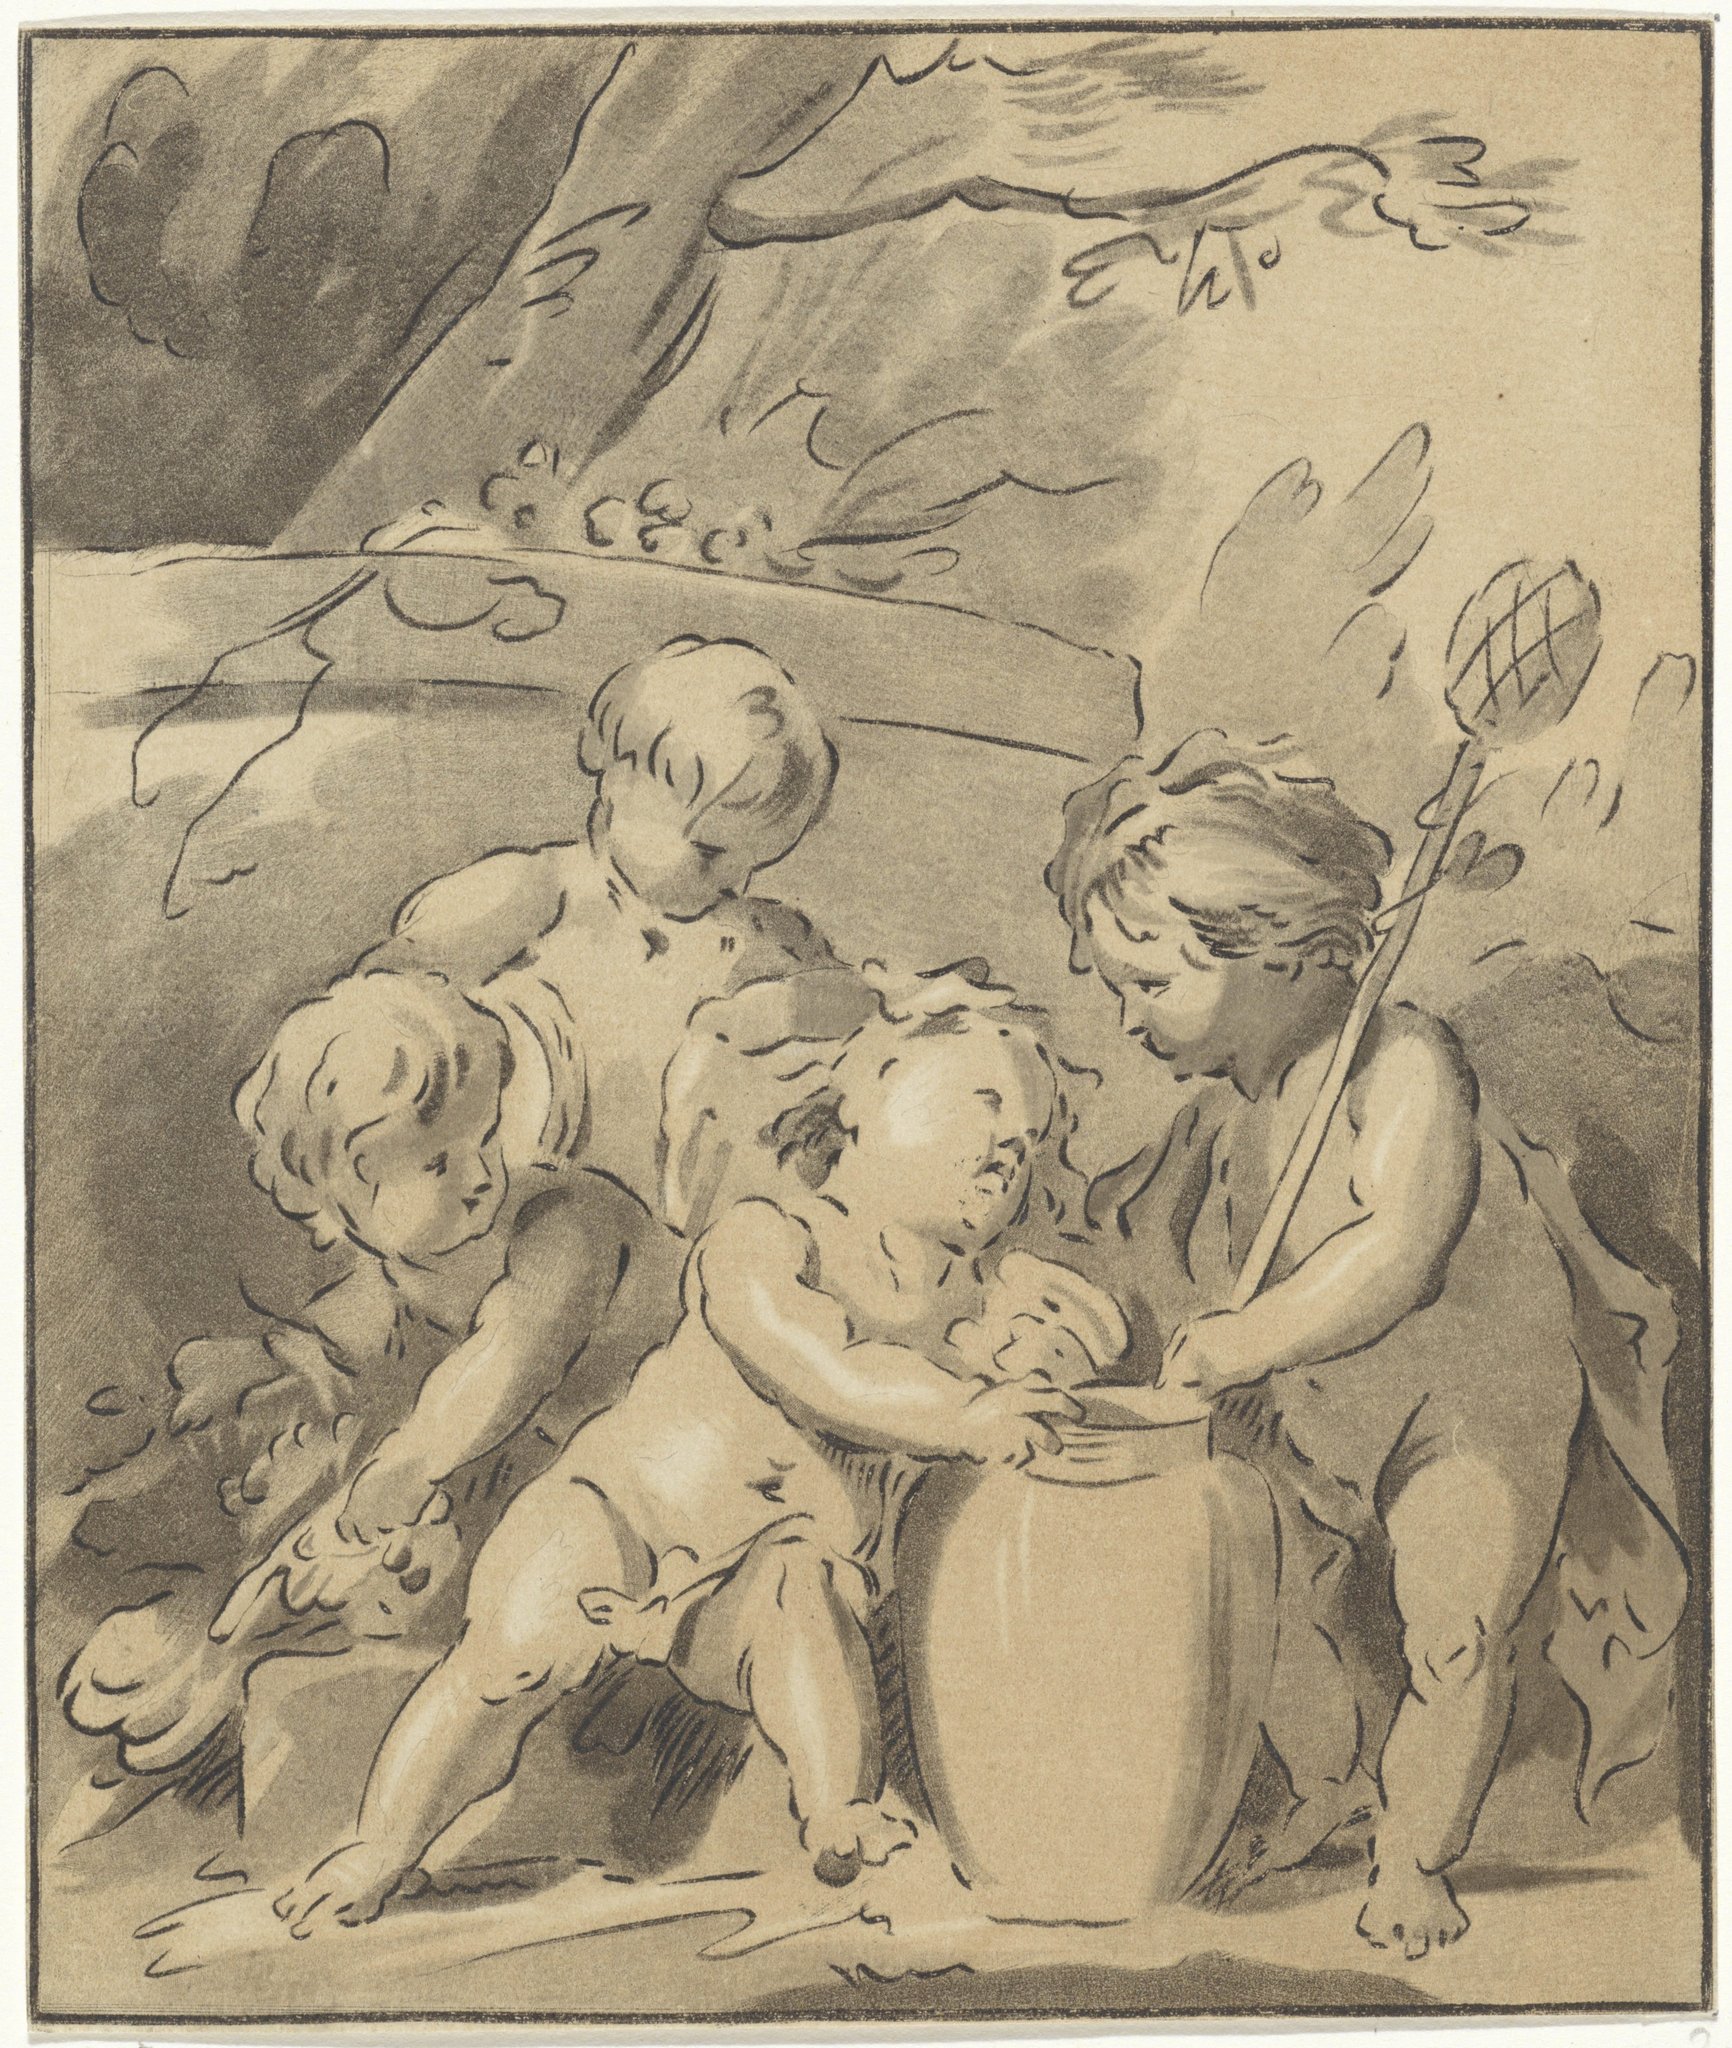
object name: print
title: Vier putti bij een vaas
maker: bernhard schreuder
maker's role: print maker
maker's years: -1780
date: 1767-1780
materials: paper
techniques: etching, rocker stamped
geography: netherlands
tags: cupids: 'amores', 'amoretti', 'putti', garden vase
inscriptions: collector's mark: Lugt 240